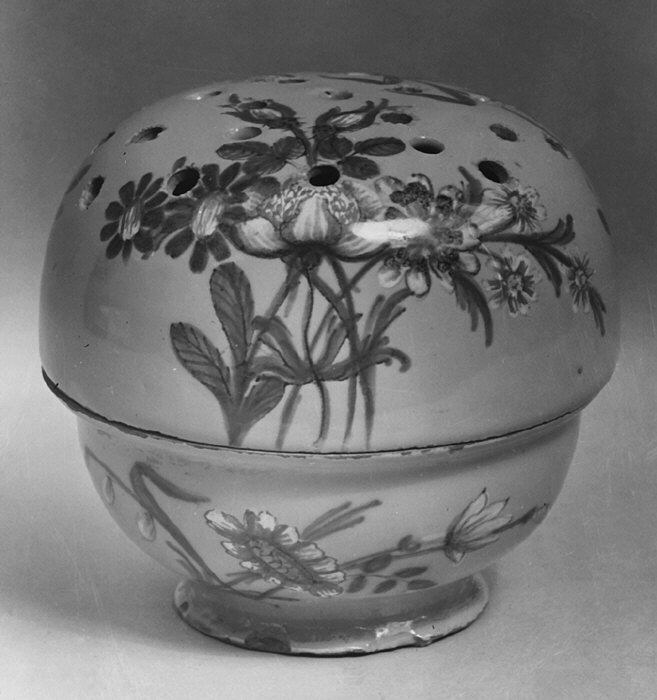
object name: boîte à savonette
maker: manufacture royale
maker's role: factory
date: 1770-1780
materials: faience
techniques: glazing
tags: flowers